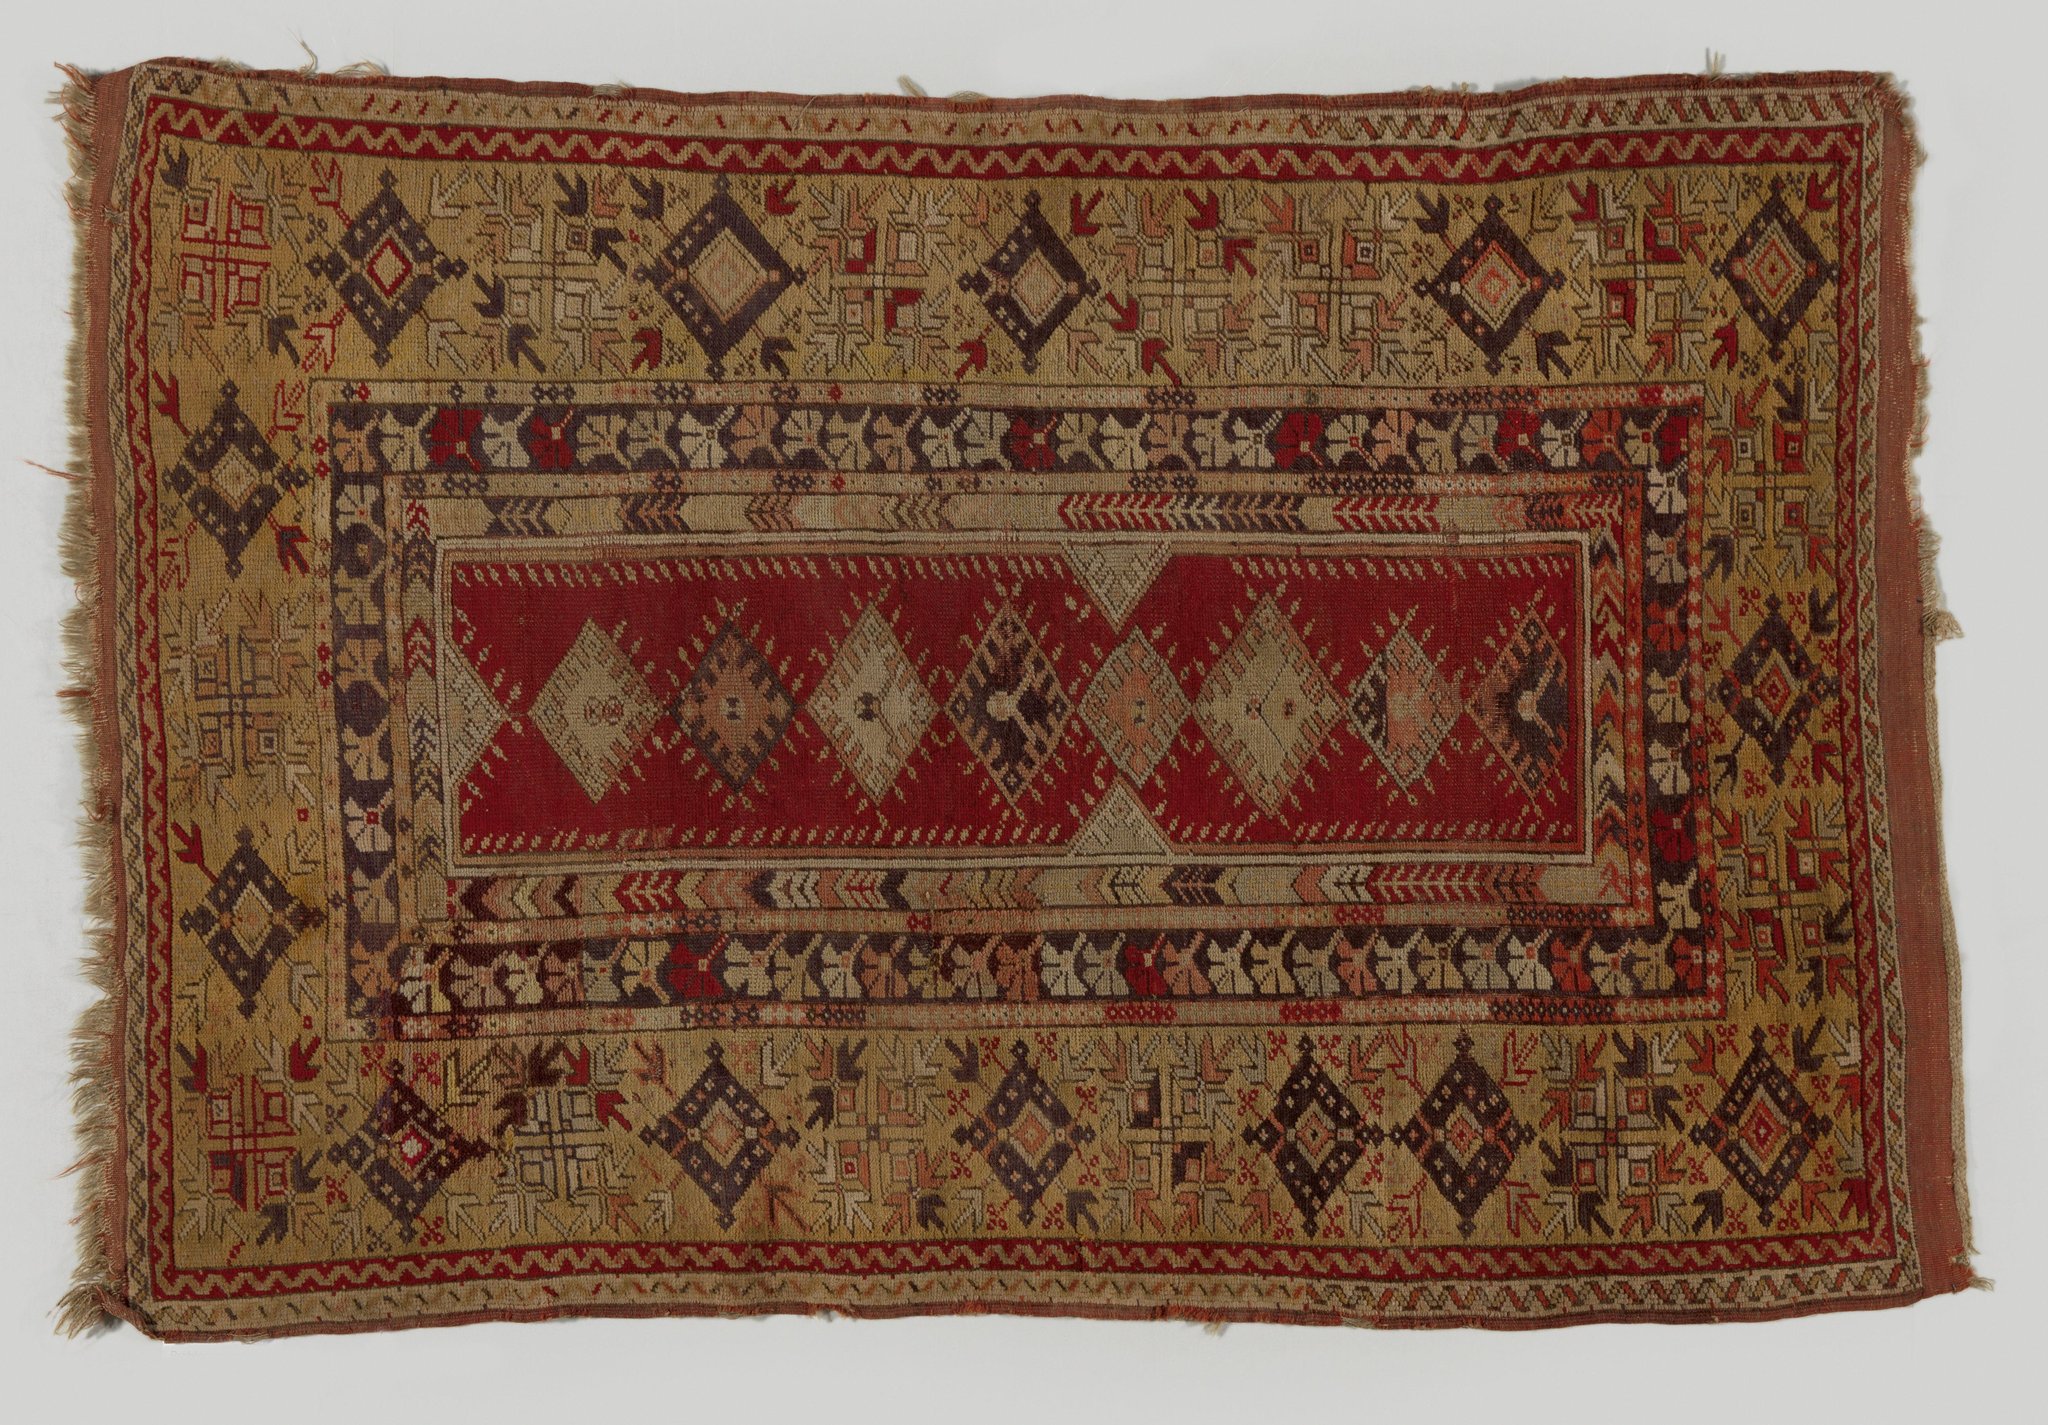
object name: prayer rug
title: Bidkleed, z.g. ruiten-bidkleed, MELAS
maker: Anonymous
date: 1800-1900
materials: wool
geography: melas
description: Bidkleed, z.g. ruiten-bidkleed, MELAS. Middenveld: op een smal, rechthoekig, even boven het midden ingesnoerd rood fond staan elkaar rakende ruiten, in roze en paars. Randen: vijfvoudig. De breedste is geel, waarop beurtelings paarse ruiten staan en viervoudige anjers in oranje, rood, wit en paars. De eerste rand met sparrentakken, de tweede met anjers en de buitenste twee in zwart en wit met zigzaglijnen.